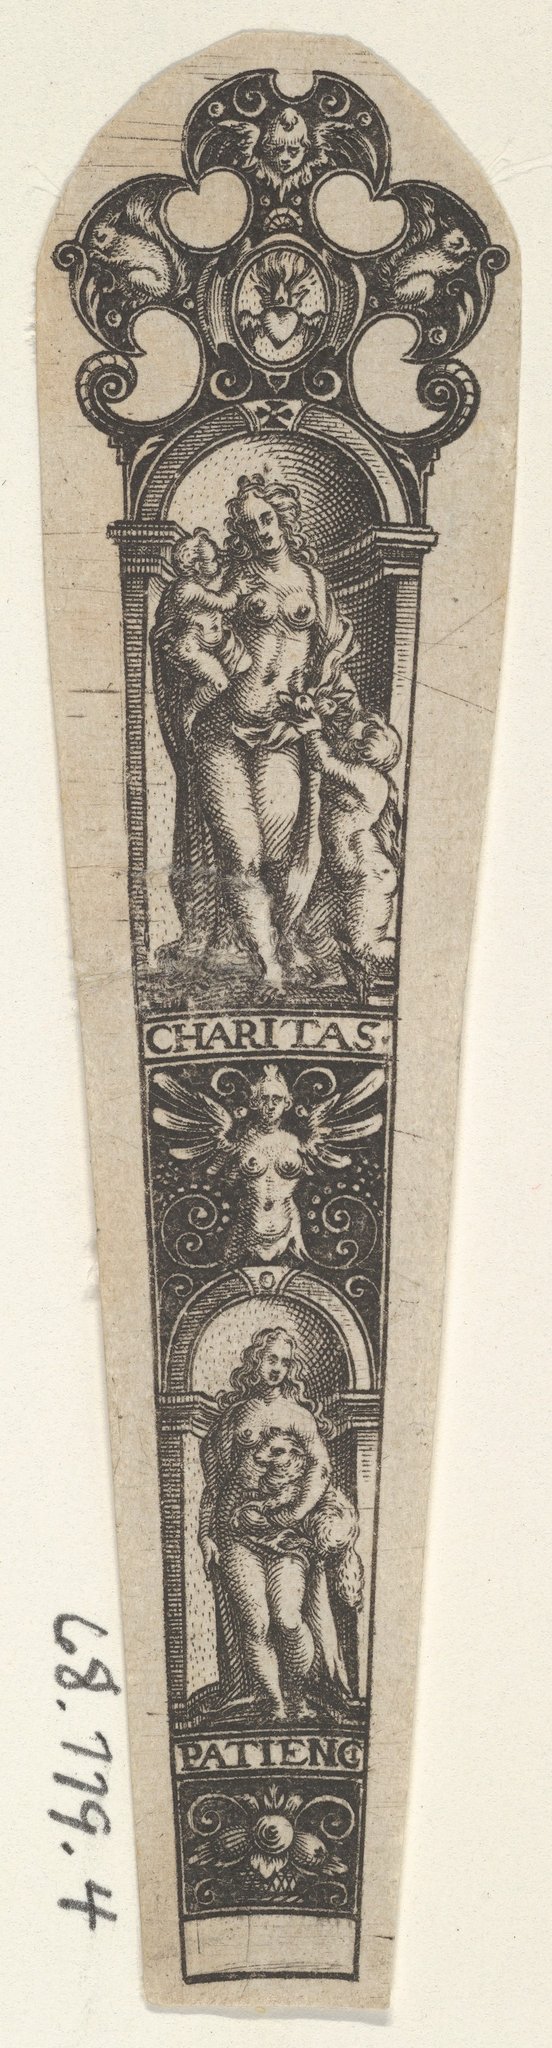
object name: print ornament architecture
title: Design for a Knife Handle with Personifications of Charity and Patience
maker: johann theodor de bry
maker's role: artist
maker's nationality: netherlandish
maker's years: 1561-1623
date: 1580-1600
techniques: embroidery, engraving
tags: hilts,infants,female nudes